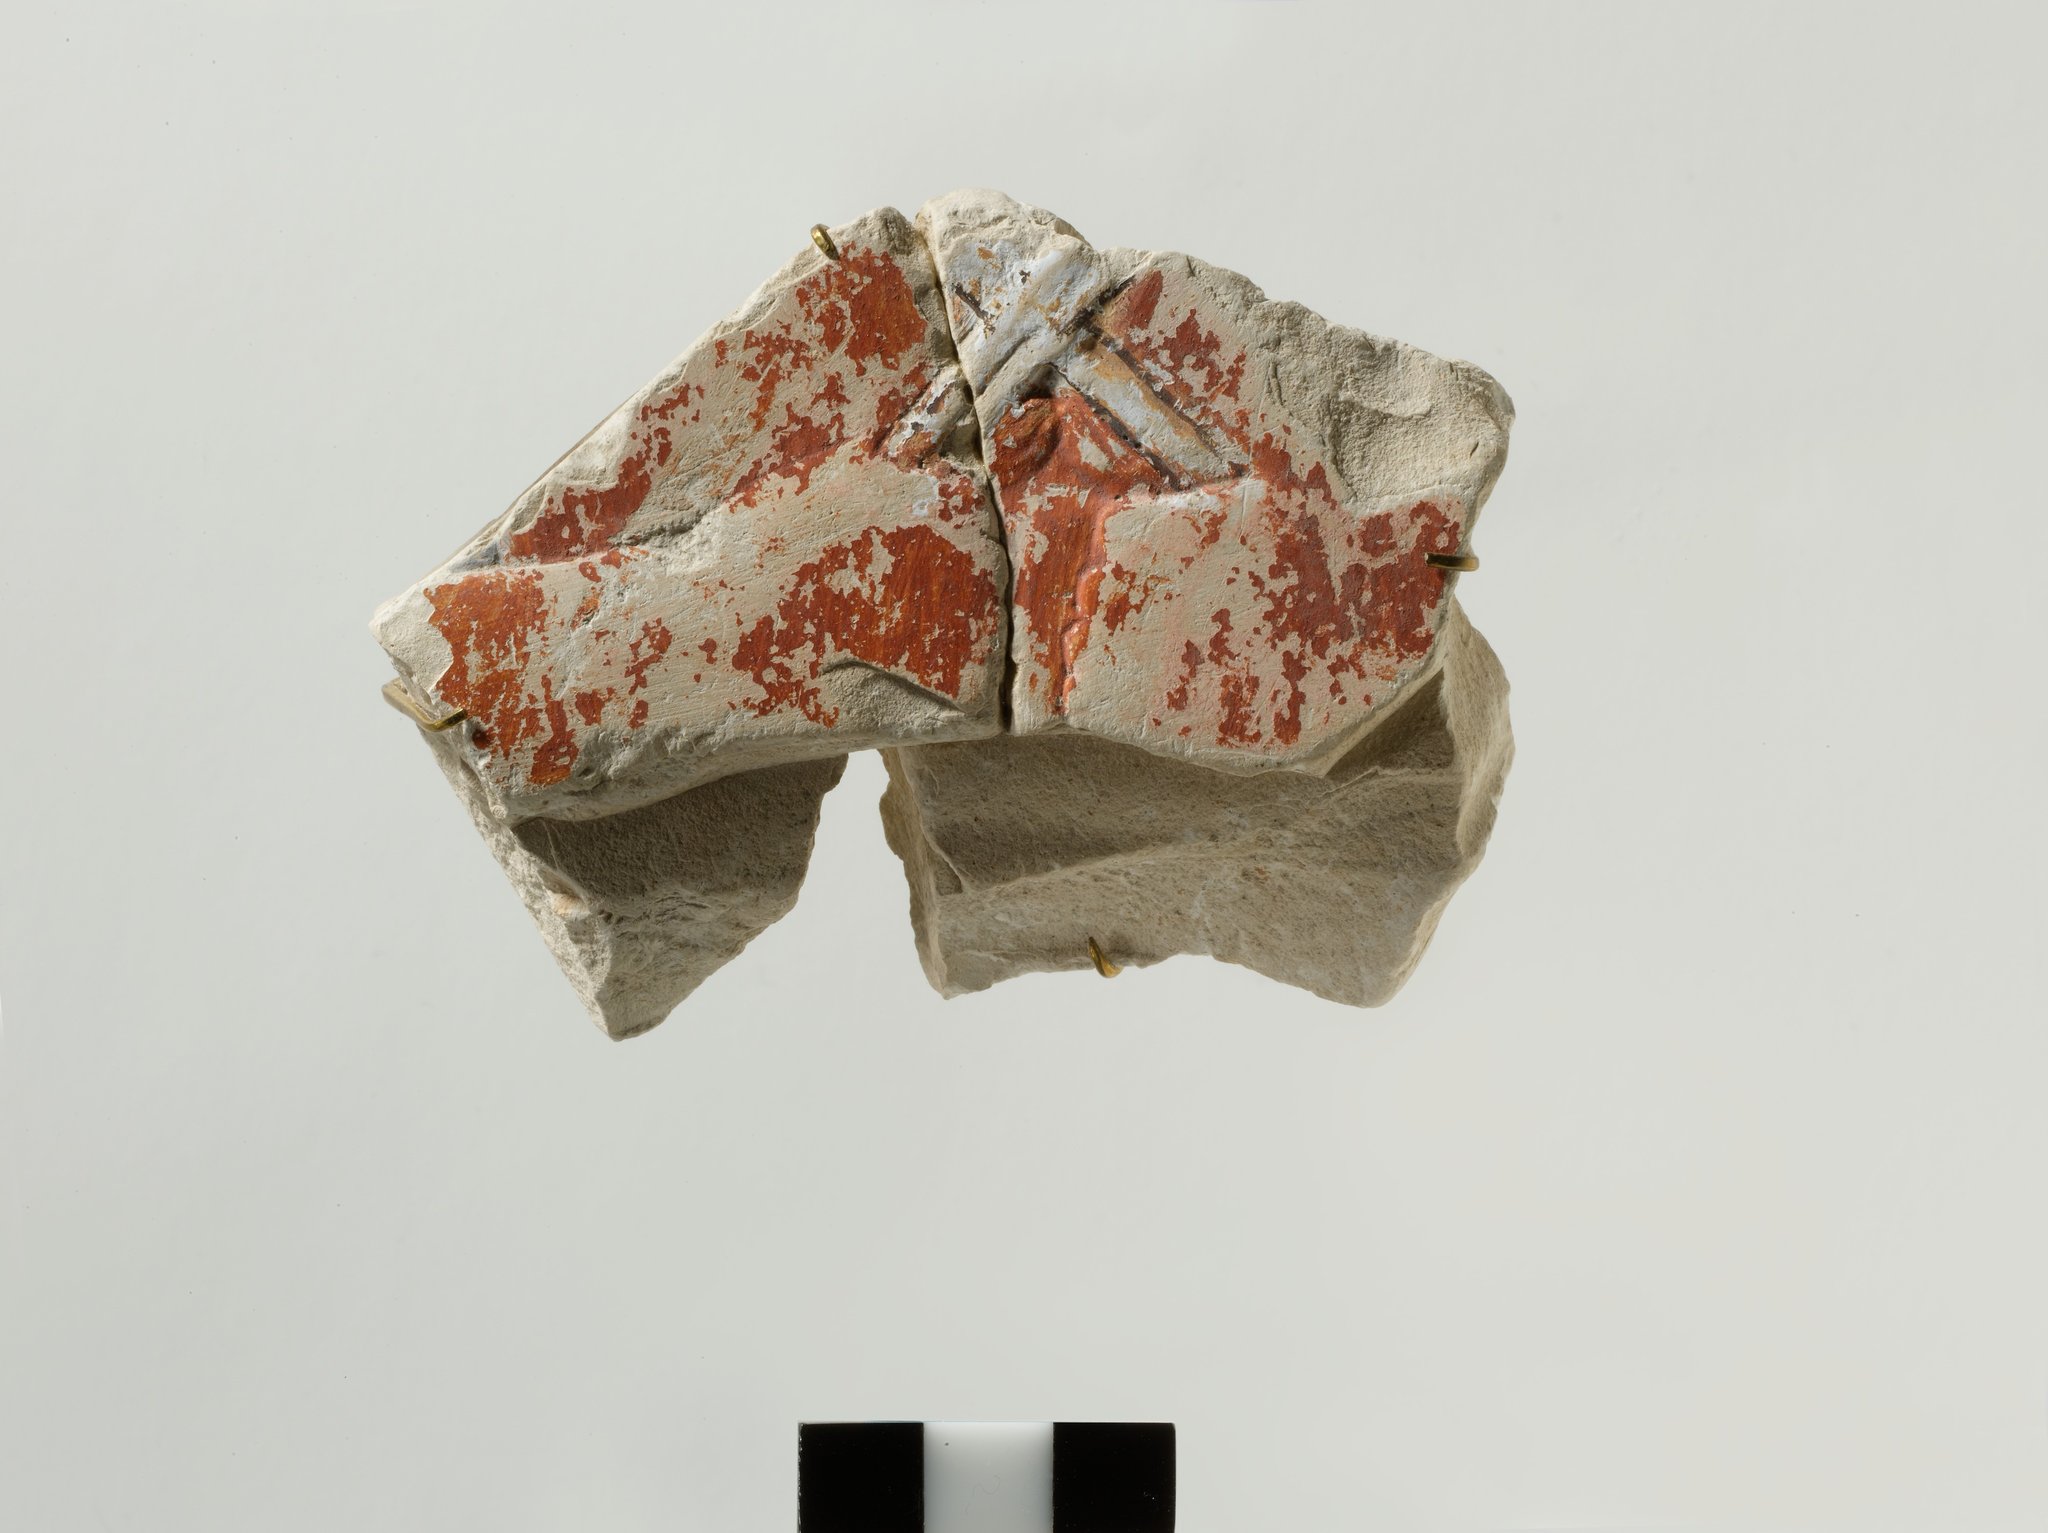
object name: relief fragment, tomb of meketre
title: Relief fragment from the tomb of Meketre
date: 1981-1975 BCE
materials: limestone, paint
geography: egypt